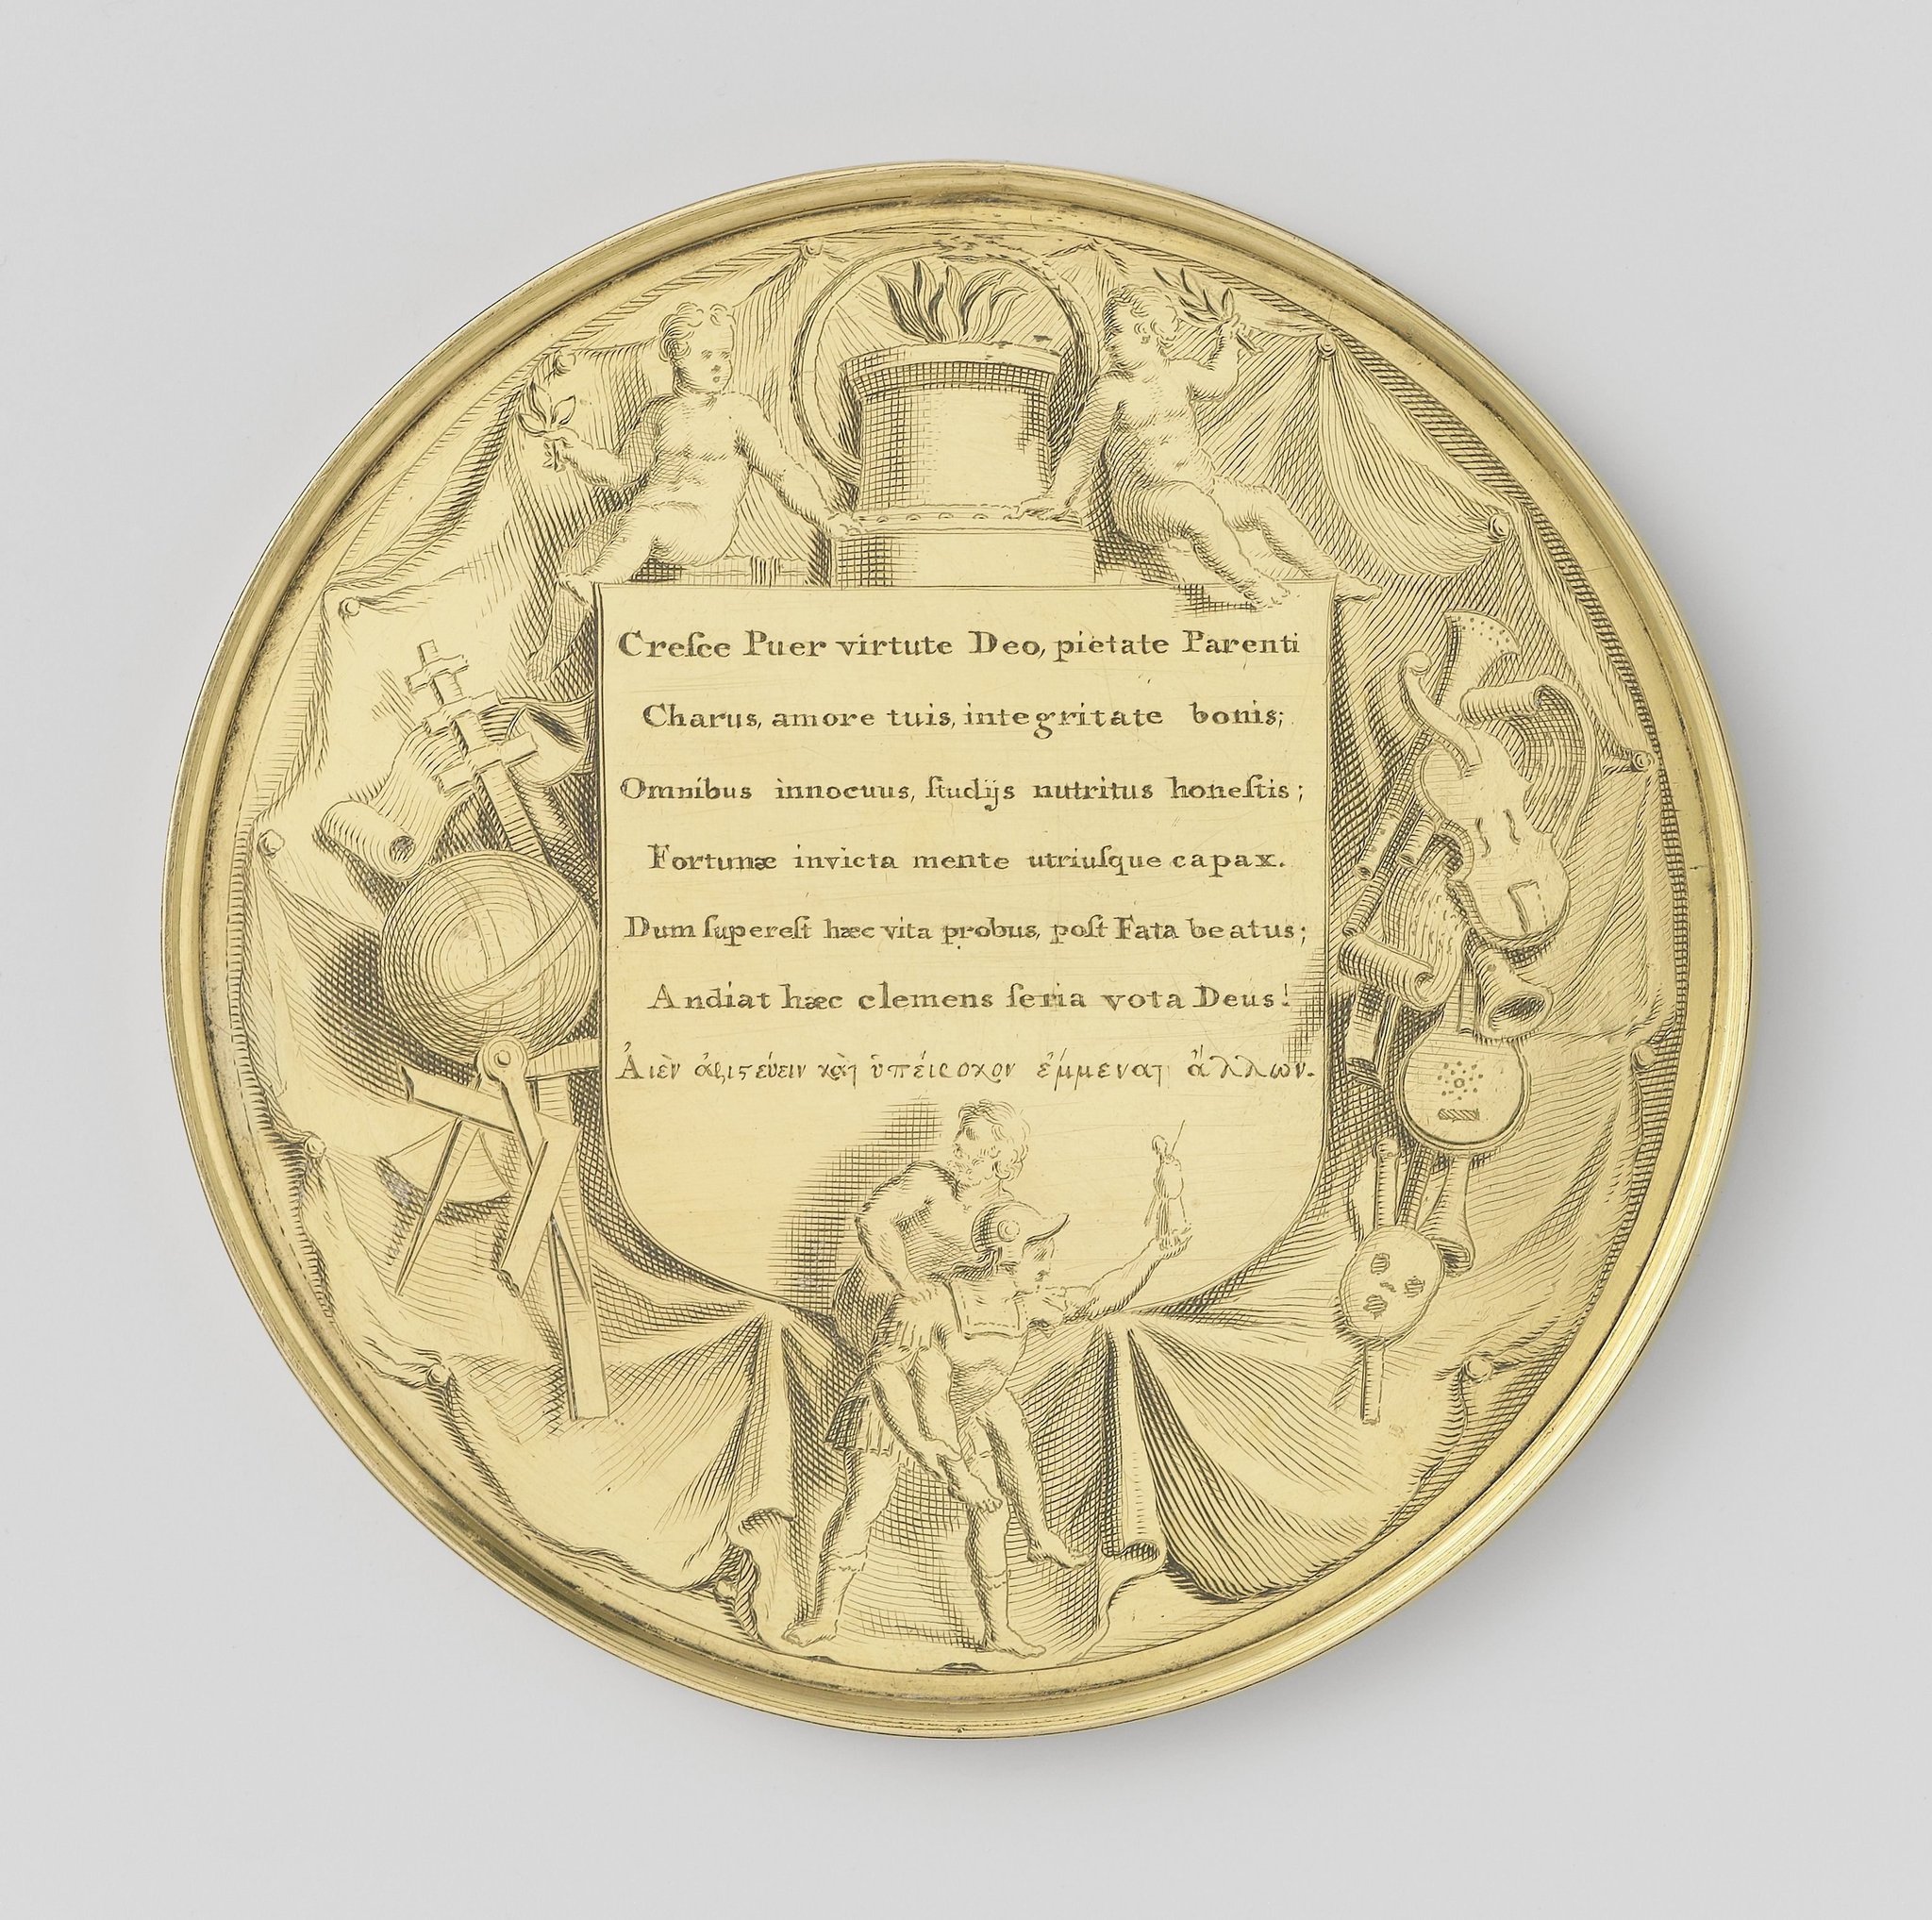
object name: medal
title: Medal Given by Isaac Pontanus to his Grandson on his Eighth Birthday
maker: Anonymous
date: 1688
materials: gold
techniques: engraving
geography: amsterdam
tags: amsterdam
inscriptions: inscription: ‘???? ???ste?e?? ?a? ‘?pe?????? ?µµe?a? ?????’, inscription: ‘EX FILIA / CATHARINA / NEPOTI SUAVISSIMO / HENRICO VAN BEEK / POST SECUNDUM QUADRIENNIUM / TERTII NATALITIA / CELEBRANTI IPSO INTERCALARI / DIE / ANNI / MDCLXXXVIII / D.D. IN AVITI FAVORIS / MONUMENTUM / IS. POTANUS’, inscription: ‘Cresce puer virtute Deo, pietate Parenti / Charus amore tuis, integritate bonis; / Omnibus innocuus, studiis nutritus honestis; / Fortunae invicta Mente utruisque capax. / Dum superest haec vita probus, post Fata beatus; / Audiat haec clemens feria vota Deus:’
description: In the past, important events were graced with a medal, especially in well-to-do families. The occasion for this was usually a birth, wedding, or death. These medals not only remained in the family as a memento, but were also given to the guests at the baptism, wedding party, or funeral. Sometimes they were purely private in character, such as the gold medal a grandfather gave to his grandson.